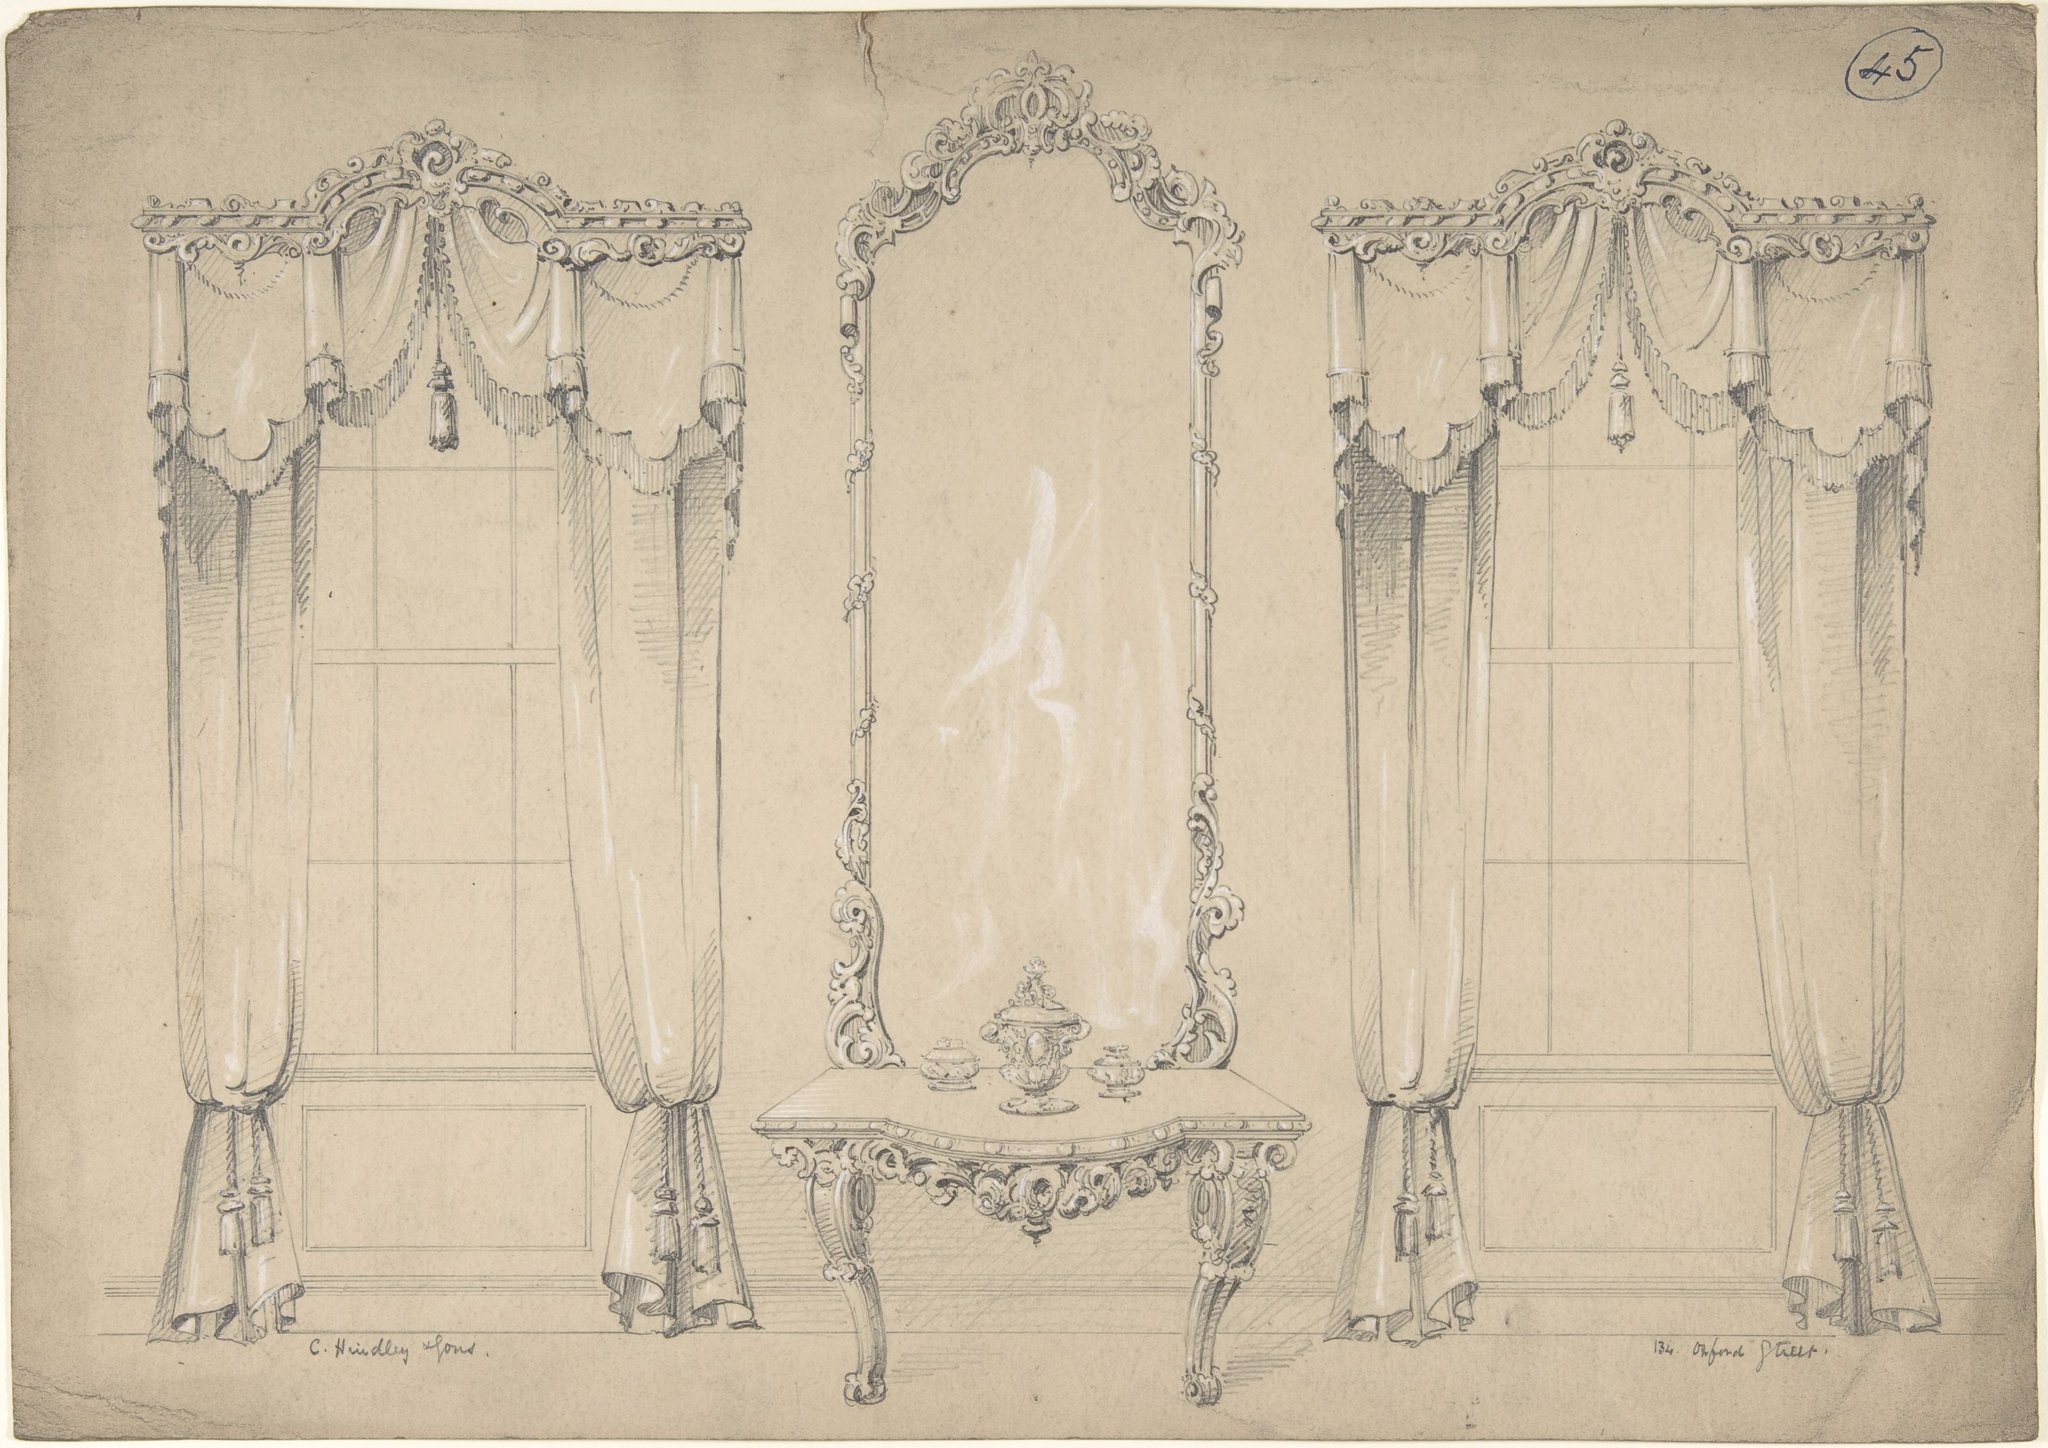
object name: drawing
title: Design for Wall with Two Windows, Side Table, and Mirror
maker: charles hindley and sons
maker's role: artist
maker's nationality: british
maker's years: 1841-1917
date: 1841-1884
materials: gouache, graphite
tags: windows,curtains,tables,mirrors